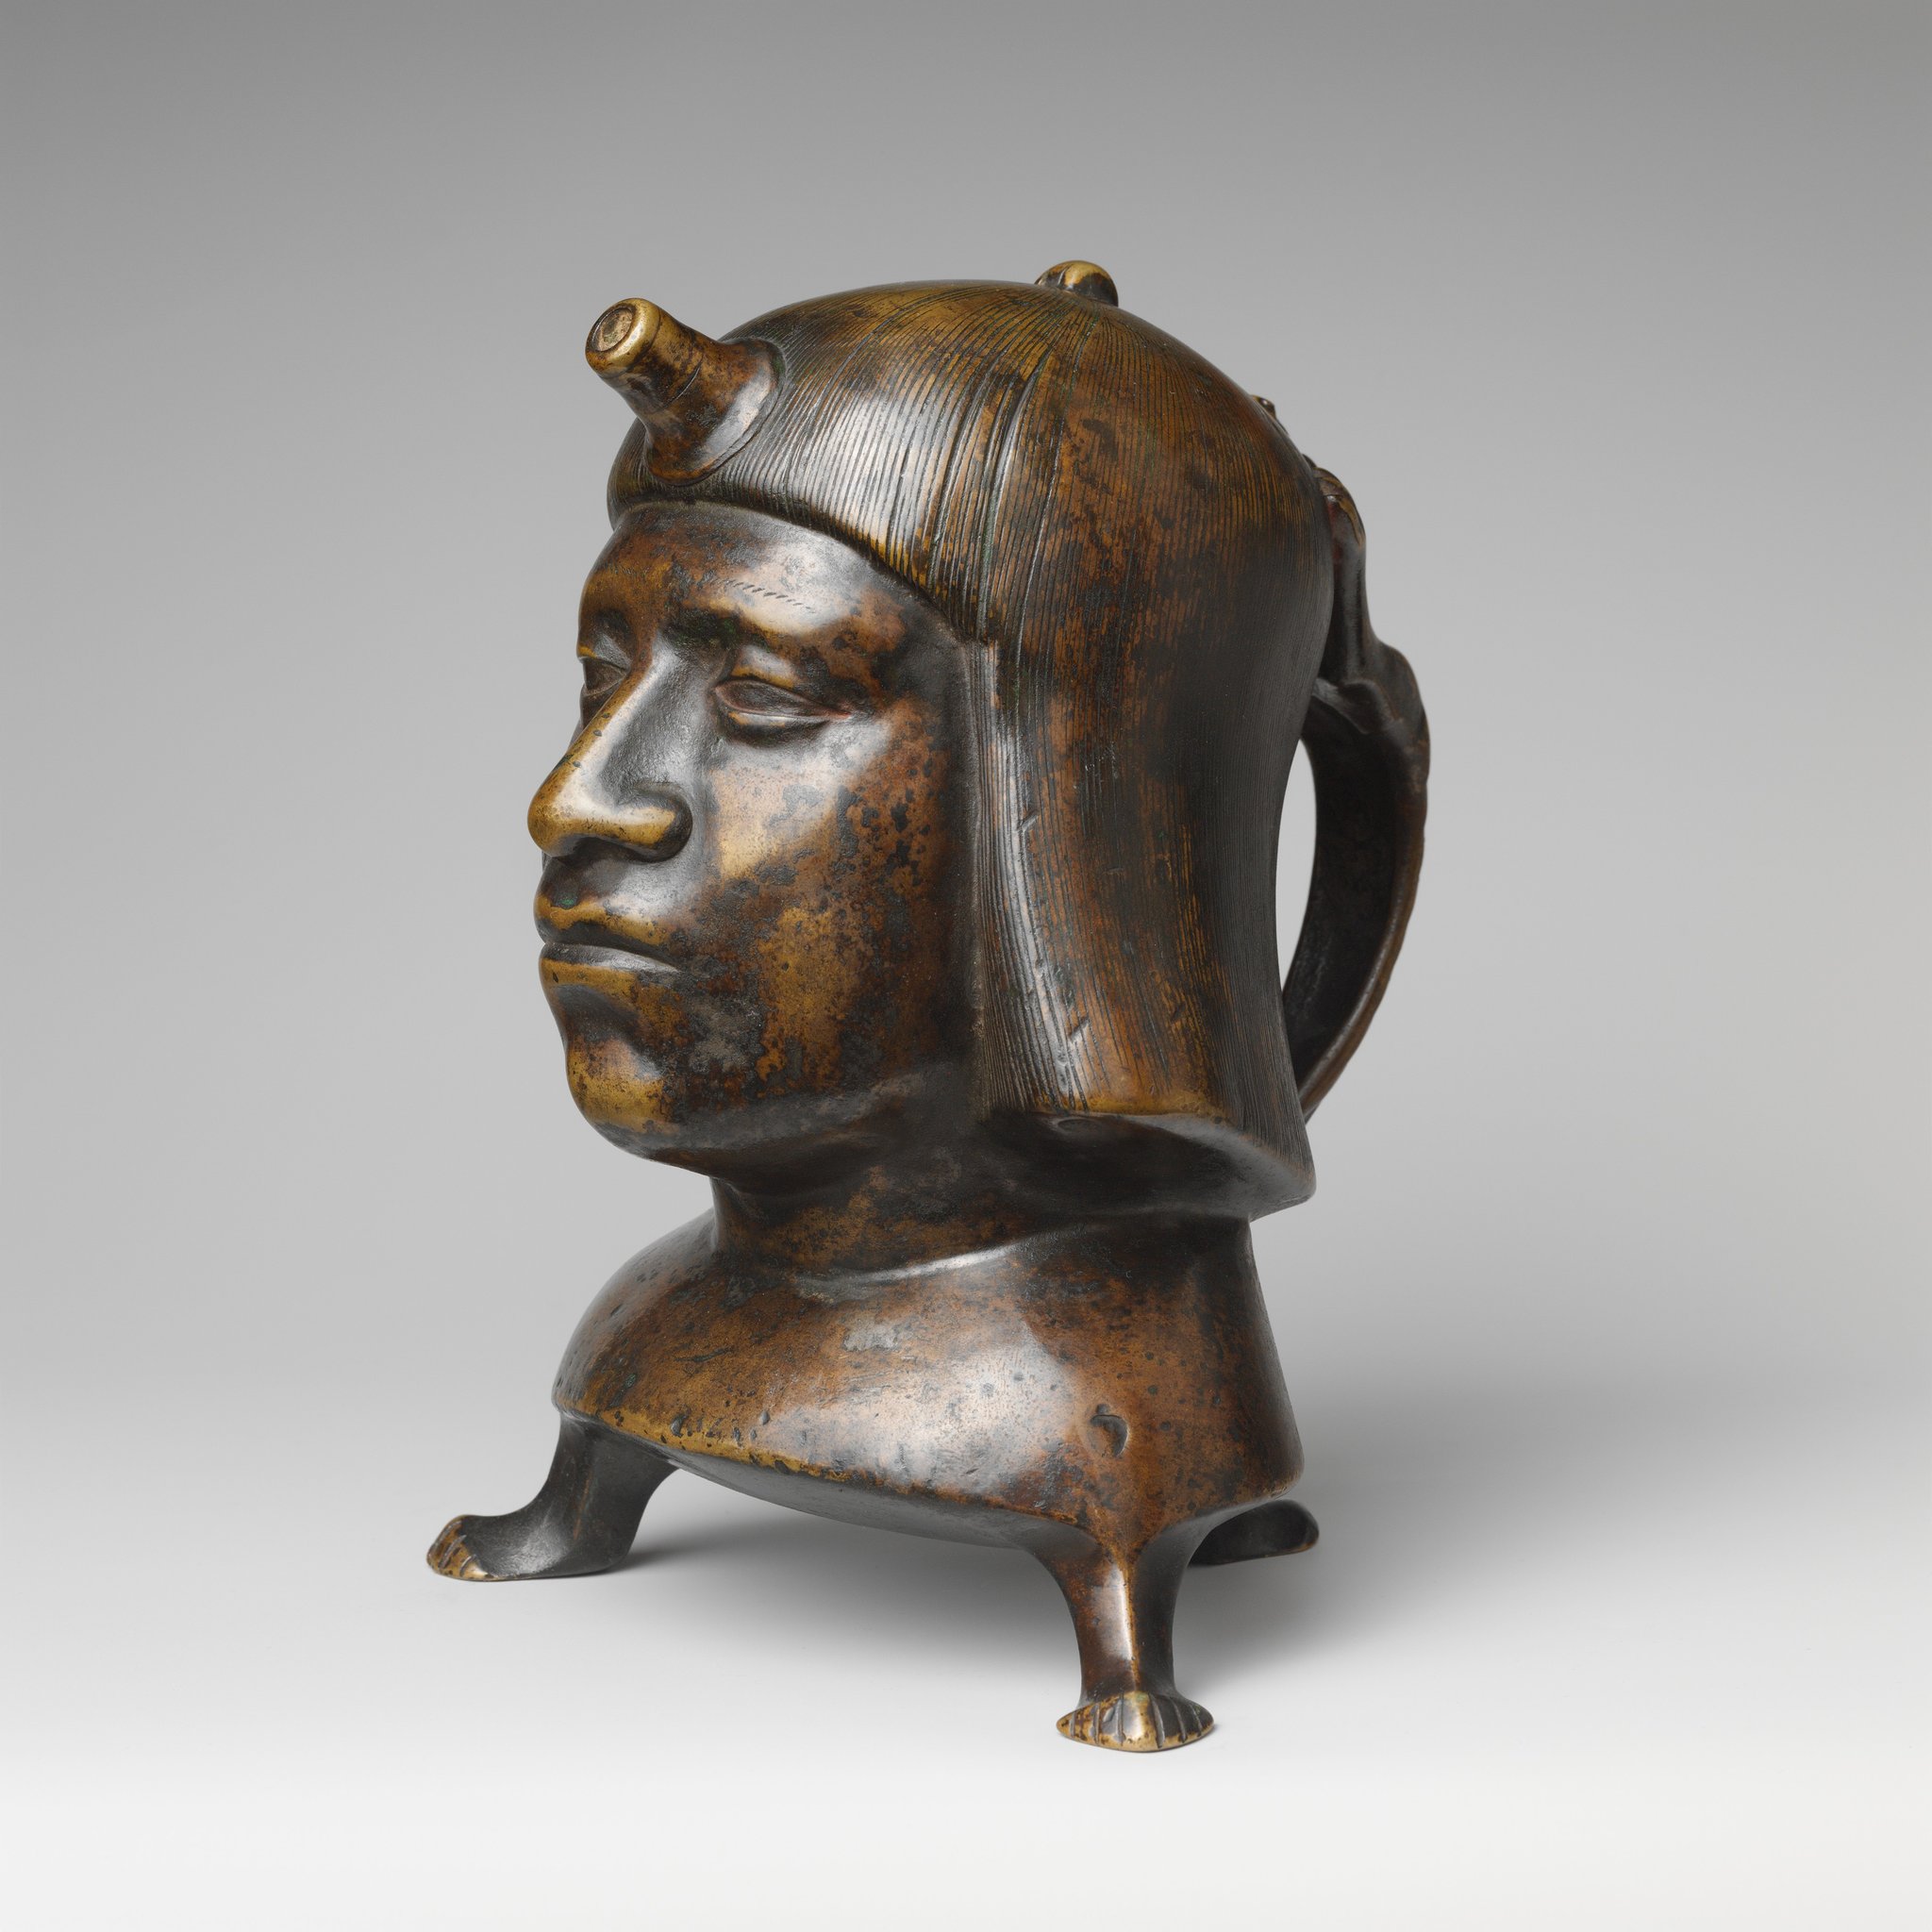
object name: aquamanile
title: Aquamanile in the Form of a Human Head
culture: french or german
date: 1876-1900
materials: bronze, copper, copper alloy, lacquer, patina, tin, zinc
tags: heads